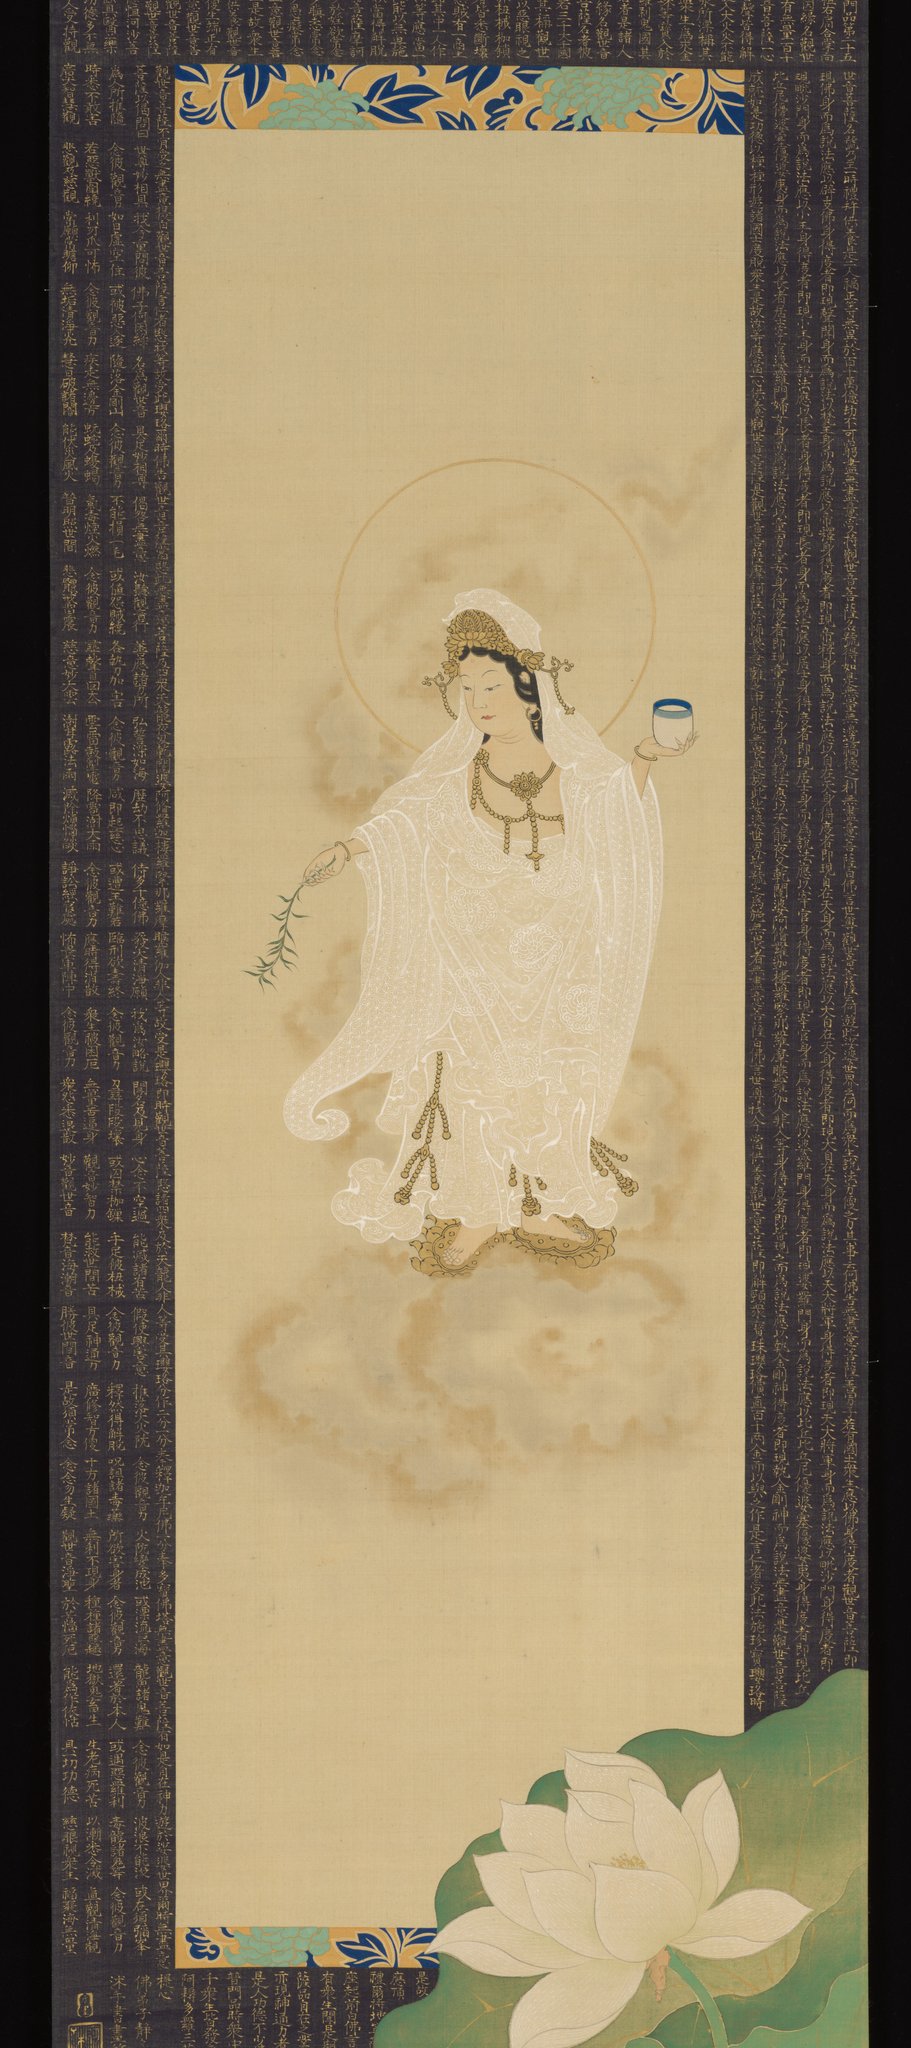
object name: hanging scroll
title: White-Robed Willow Kannon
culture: japanese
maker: suzuki shūitsu 鈴木守一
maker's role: artist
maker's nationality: japanese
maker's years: 1823-1889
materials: gold, ink, silk, silver